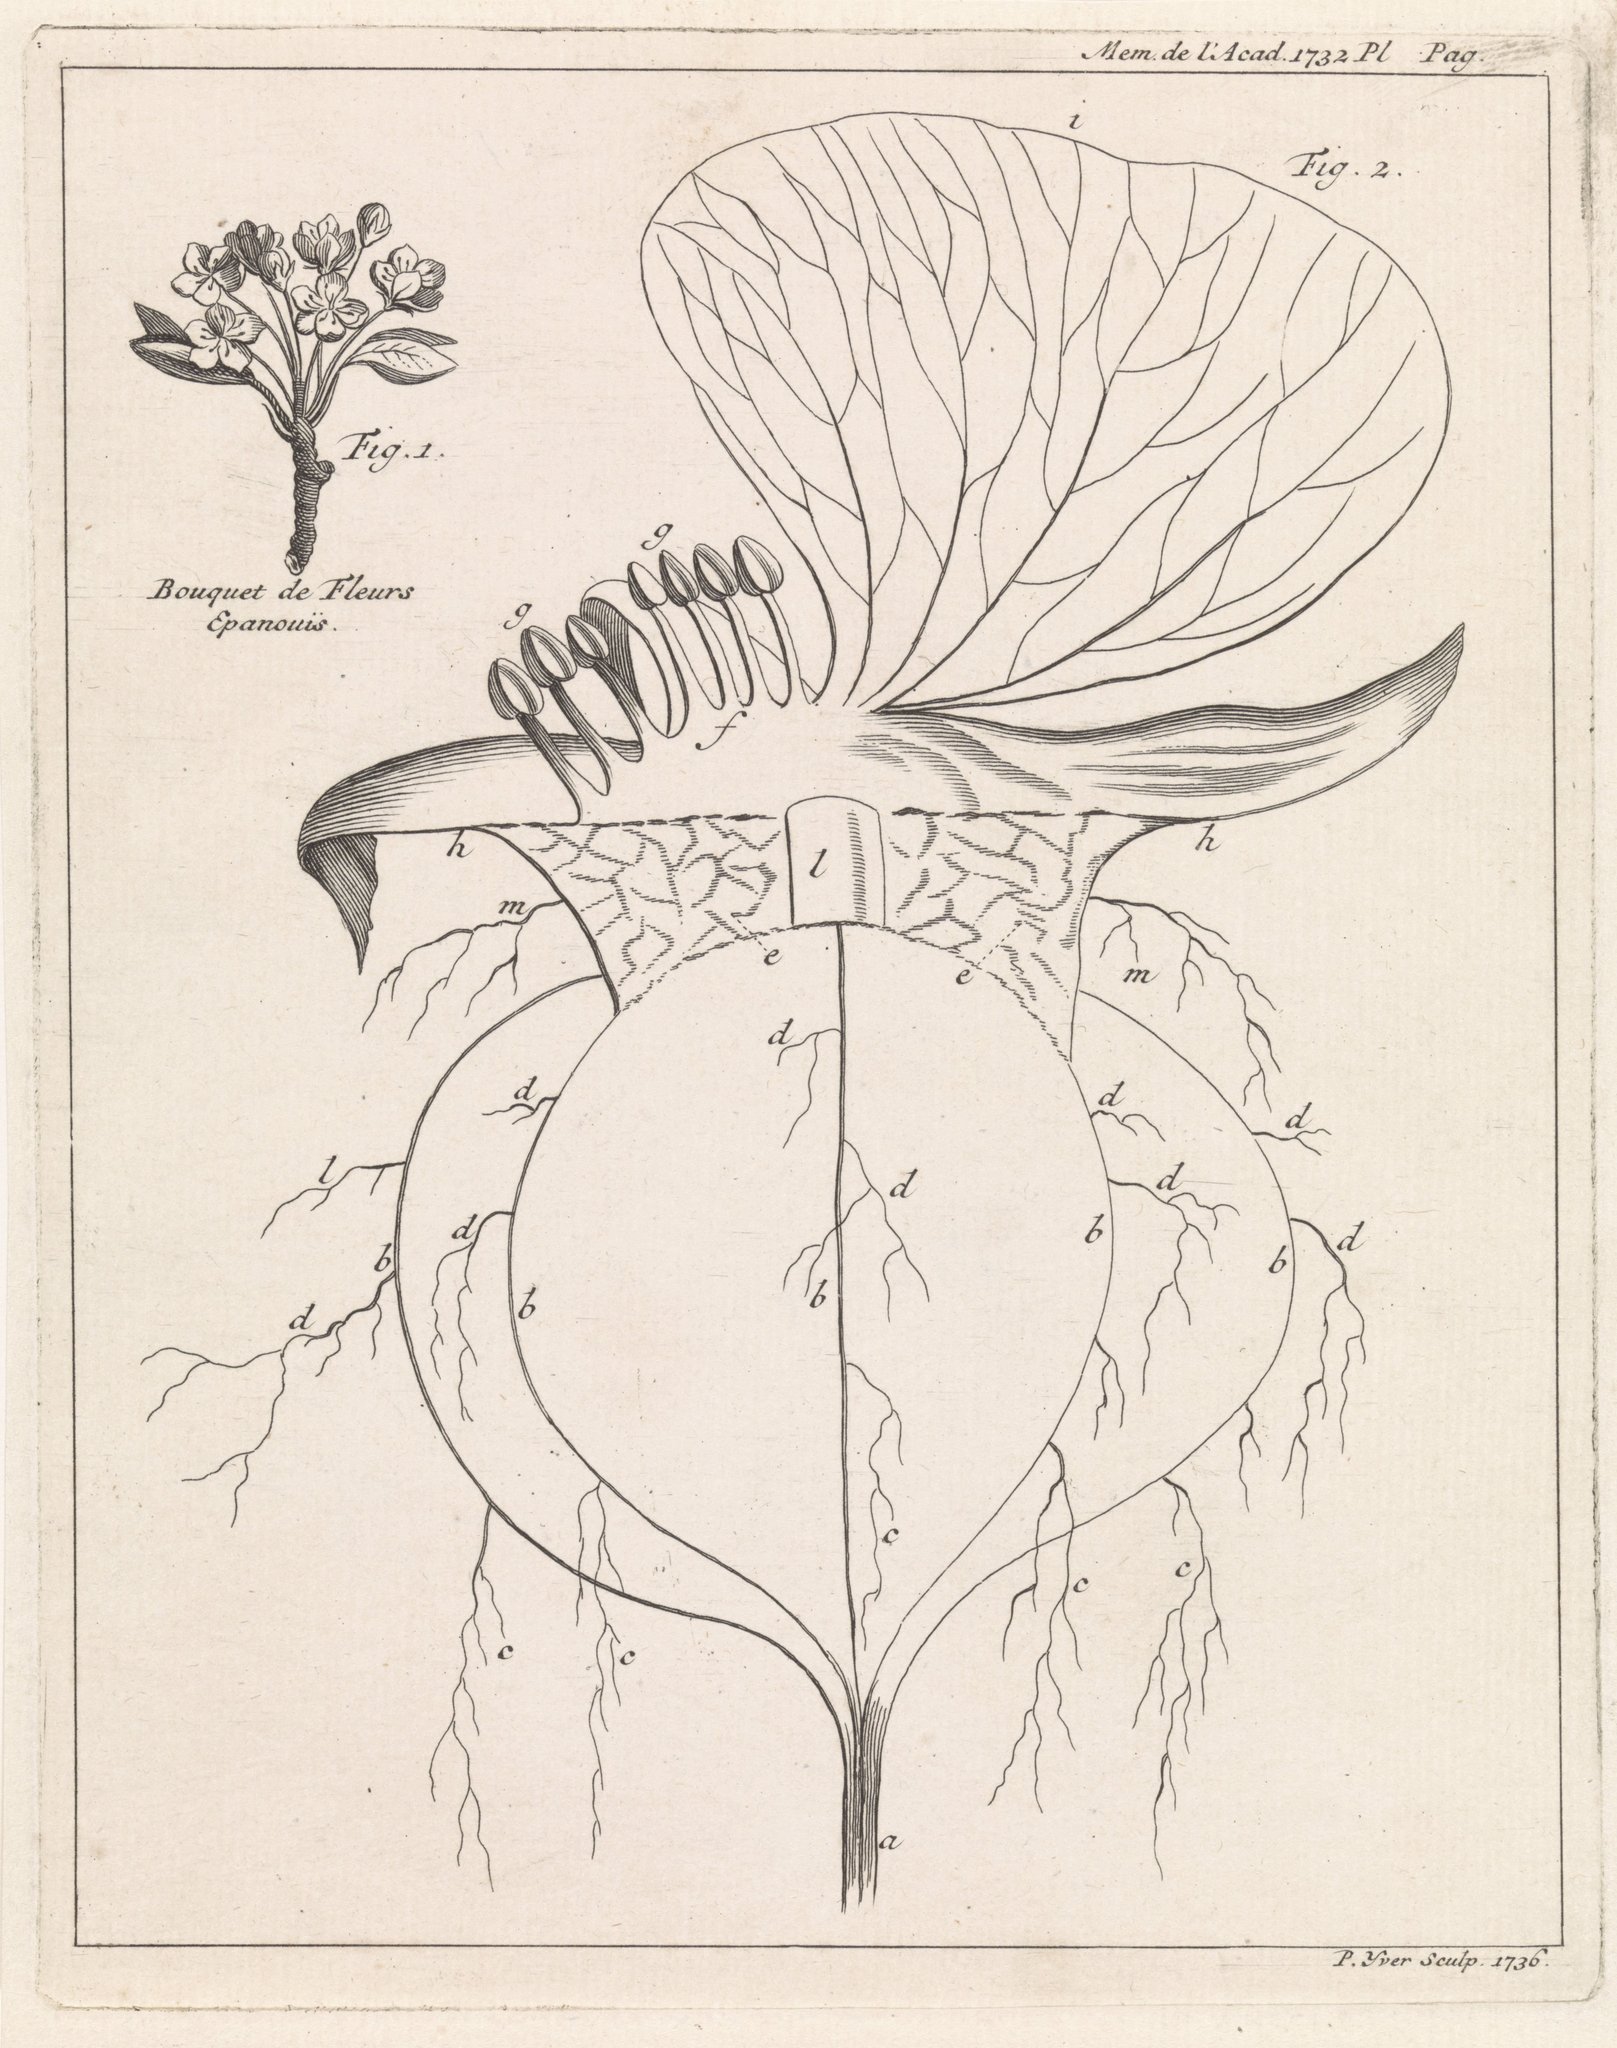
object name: print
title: Doorsnede van een bloem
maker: pieter yver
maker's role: print maker, publisher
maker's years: 1712-1787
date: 1736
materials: paper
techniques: engraving, etching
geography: amsterdam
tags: flowers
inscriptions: collector's mark: Lugt 2233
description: Doorsnede van een bloem met in de linker bovenhoek een bos bloemen.